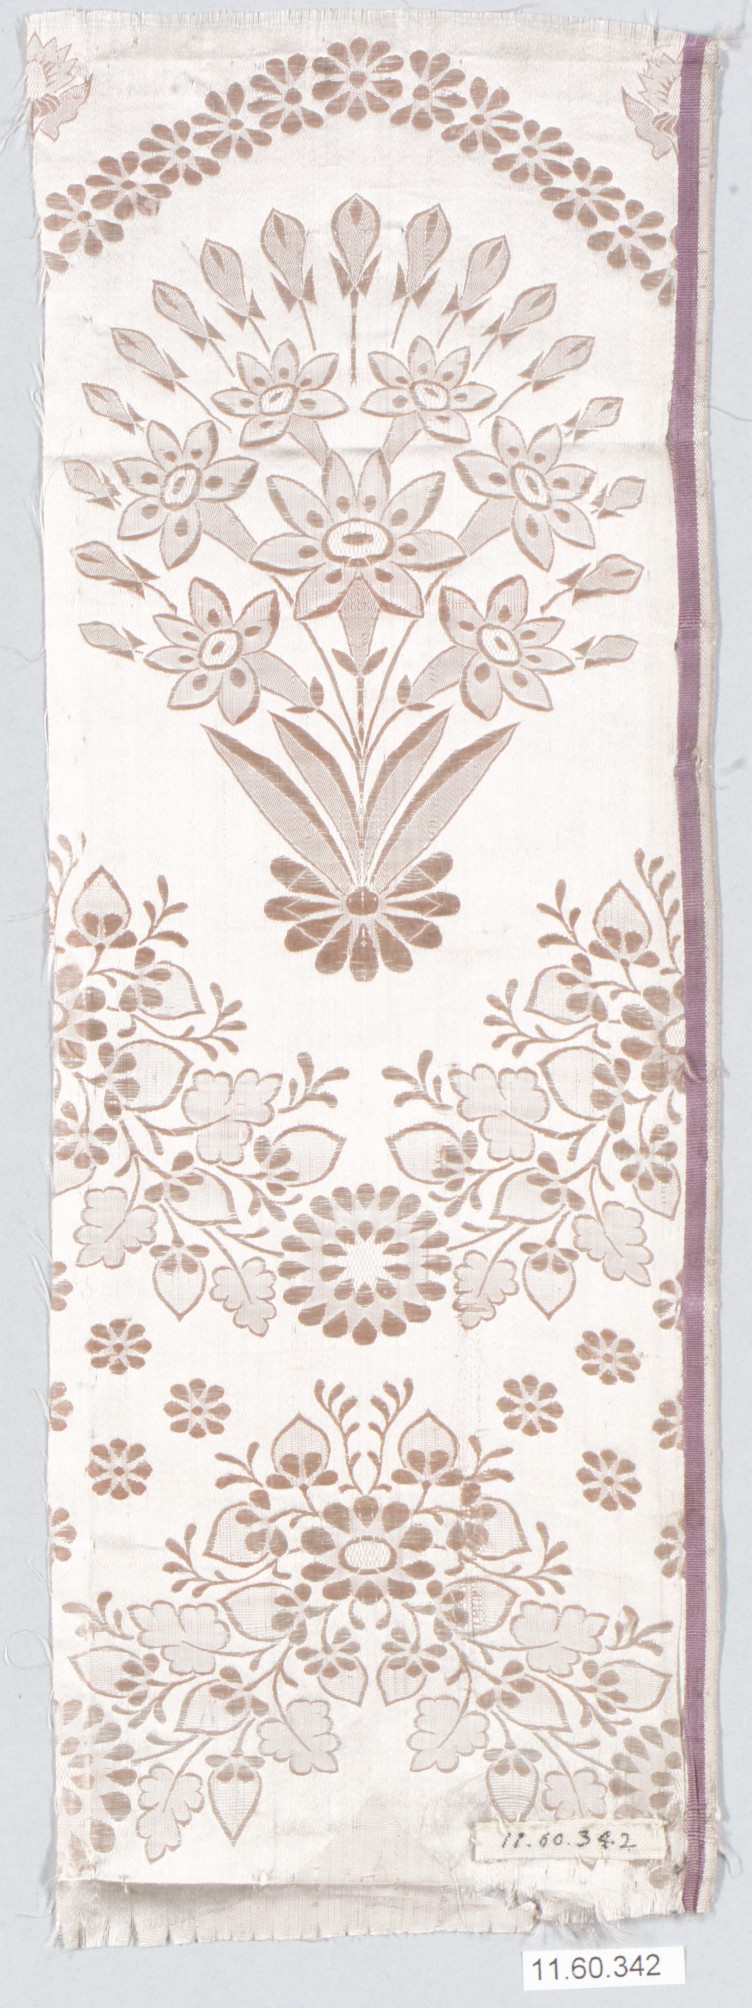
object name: fragment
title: Fragments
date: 1801-1900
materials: silk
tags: flowers,leaves